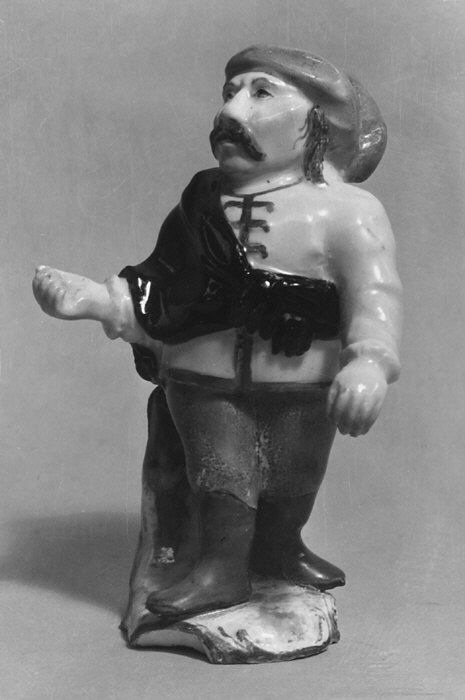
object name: figure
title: Dwarf in the uniform of a colonel of hussars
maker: höchst manufactory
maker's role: manufactory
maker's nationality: german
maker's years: 1746-1796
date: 1750-1765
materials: hard paste porcelain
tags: men